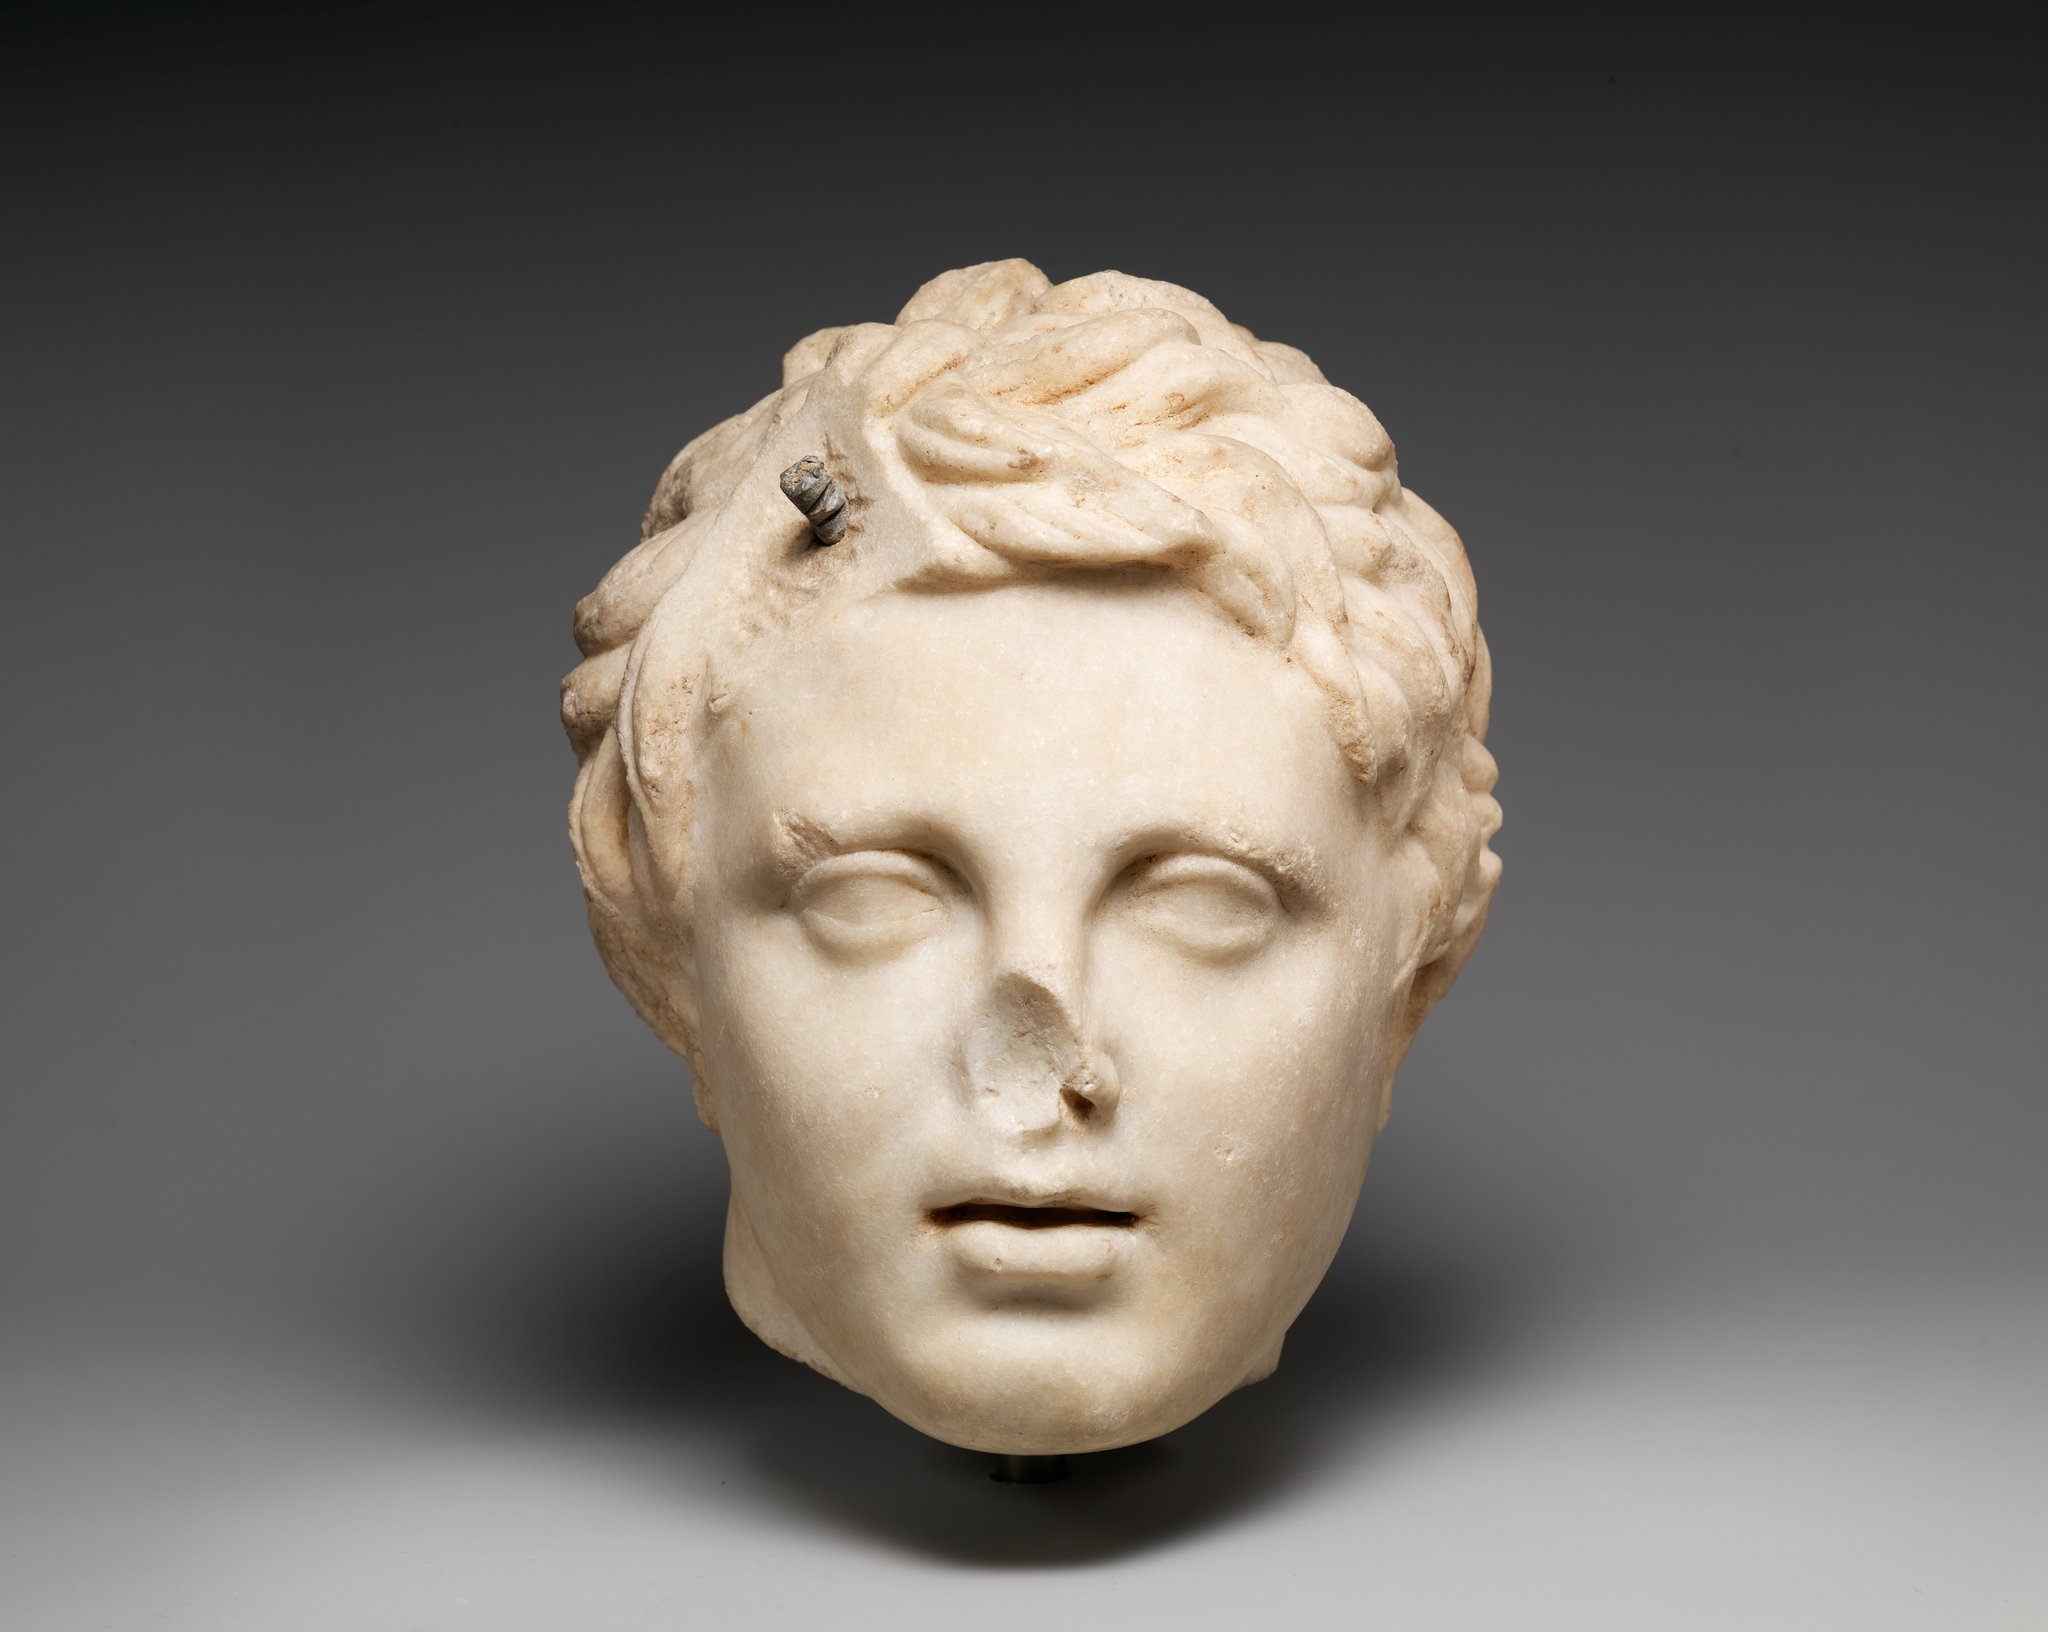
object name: head of a youth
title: Marble head of a boy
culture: roman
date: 1-100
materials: marble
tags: heads,boys